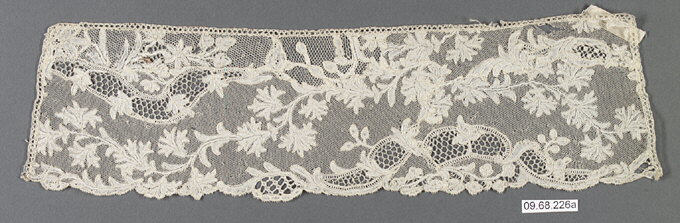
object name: strip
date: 1701-1800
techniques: lace